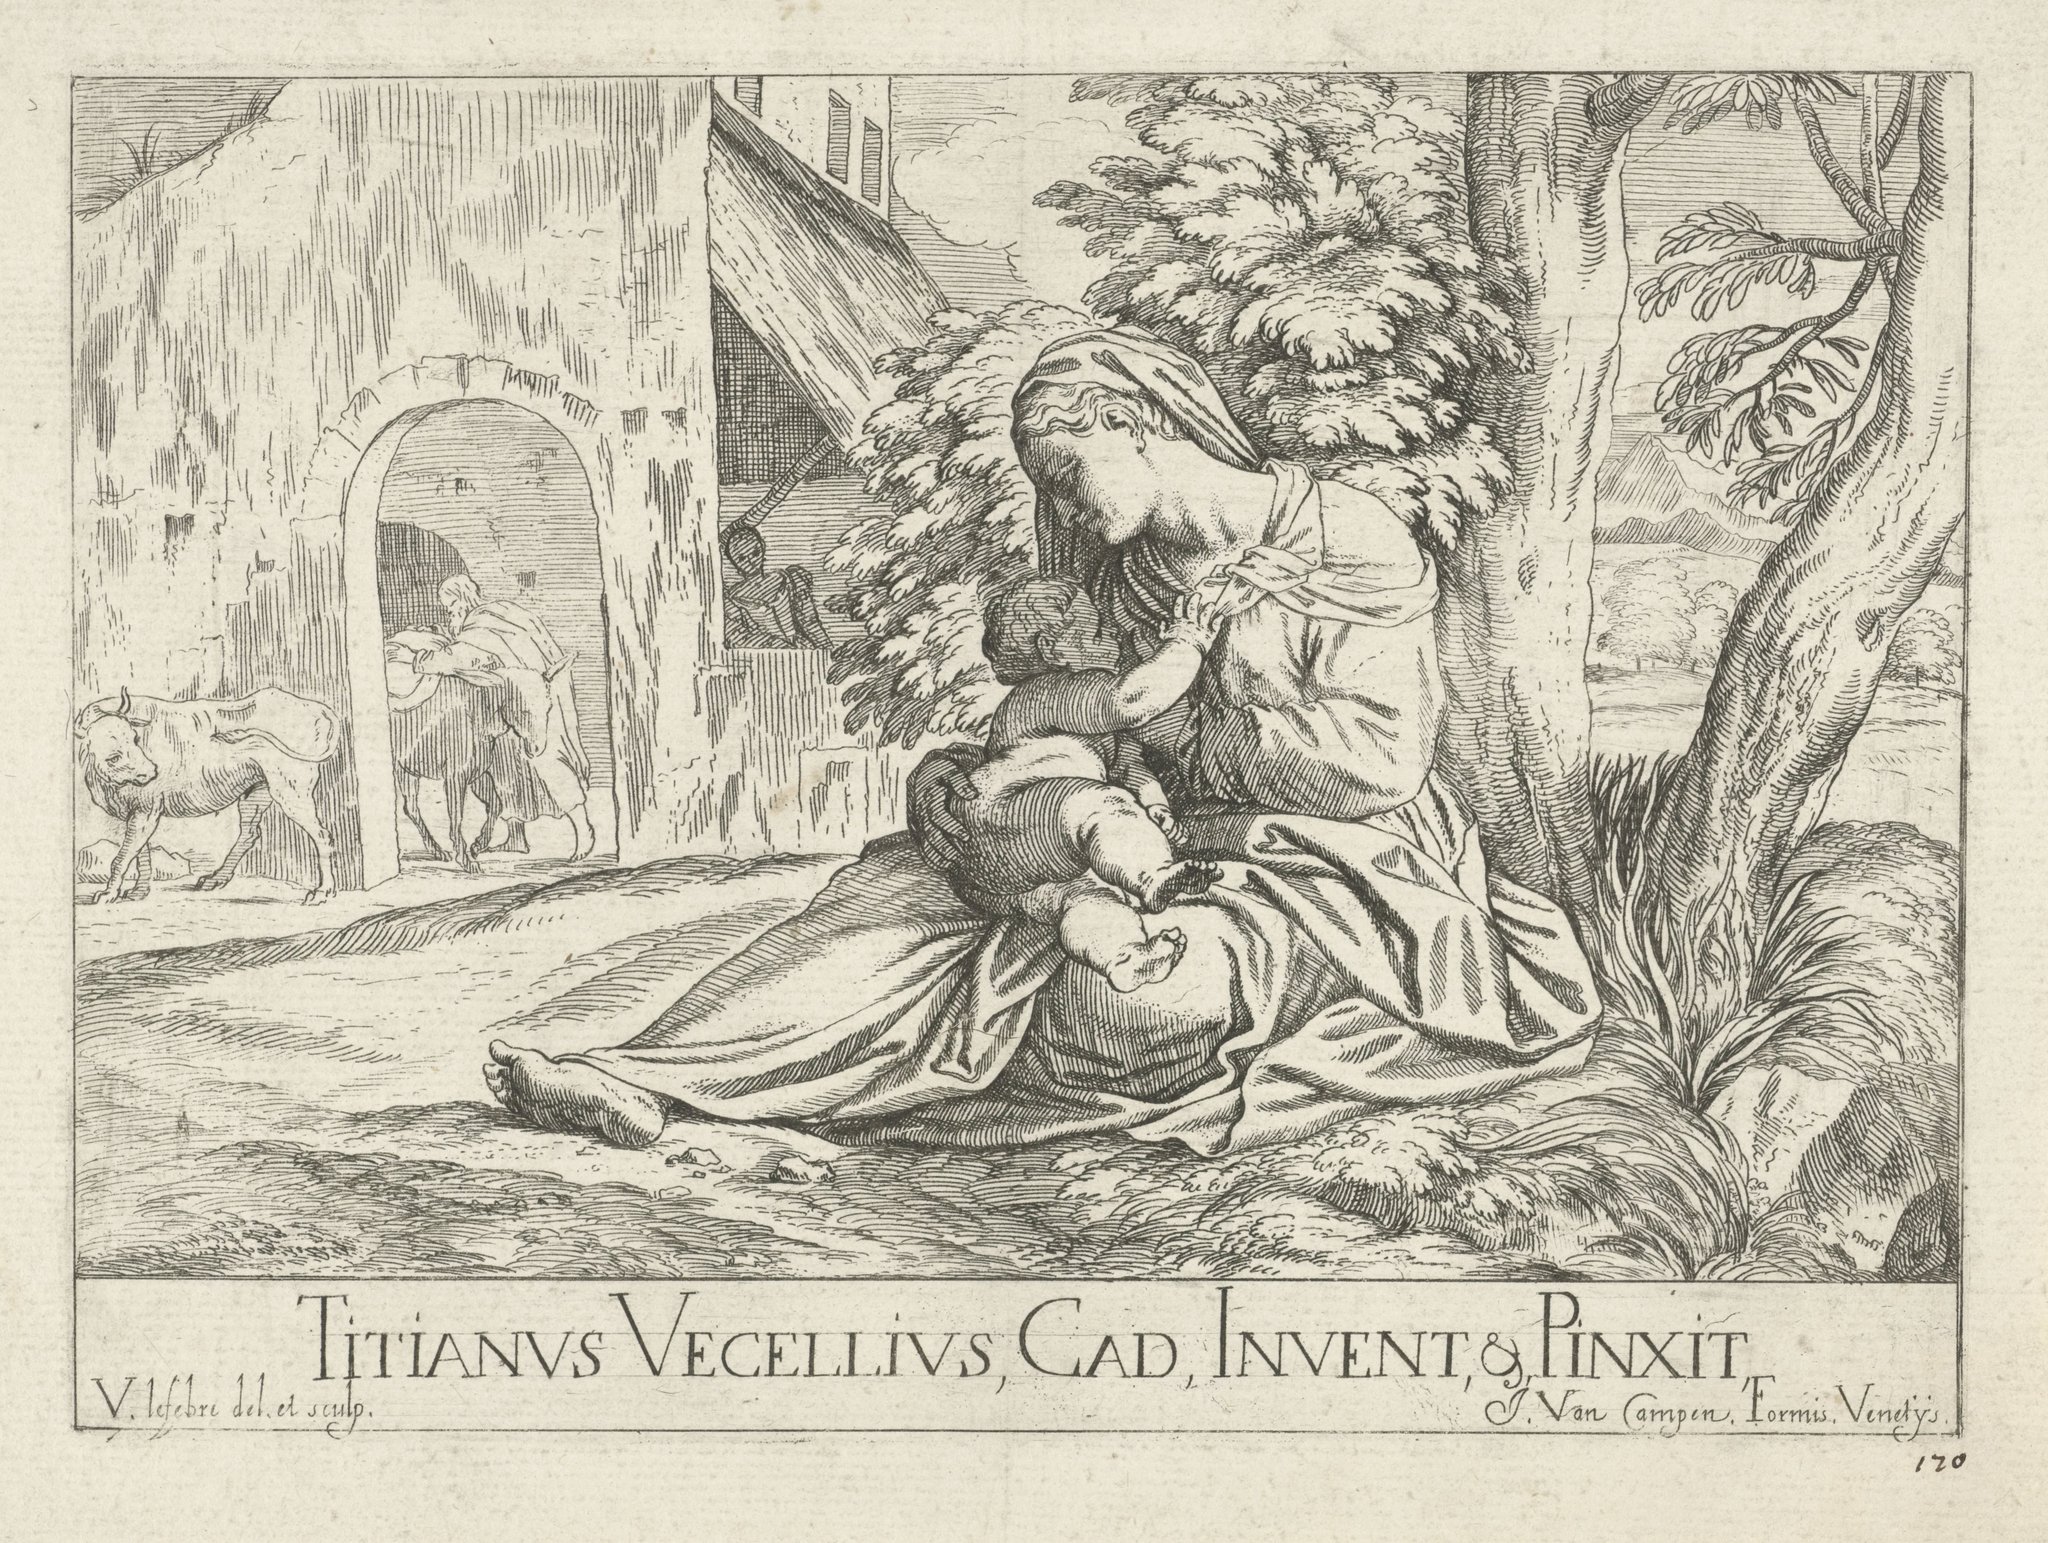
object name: print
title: Maria zoogt het Christuskind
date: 1682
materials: paper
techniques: etching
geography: venice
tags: christ-child suckling, or beginning to suckle, e.g. mary uncovering her breast ~ madonna-representations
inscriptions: number: ‘170’, collector's mark: Lugt 2228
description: Maria zit buiten een stal op de grond en geeft het Christuskind de borst. De prent maakt deel uit van een 53-delige serie prenten naar schilderijen van Titiaan en Veronese.